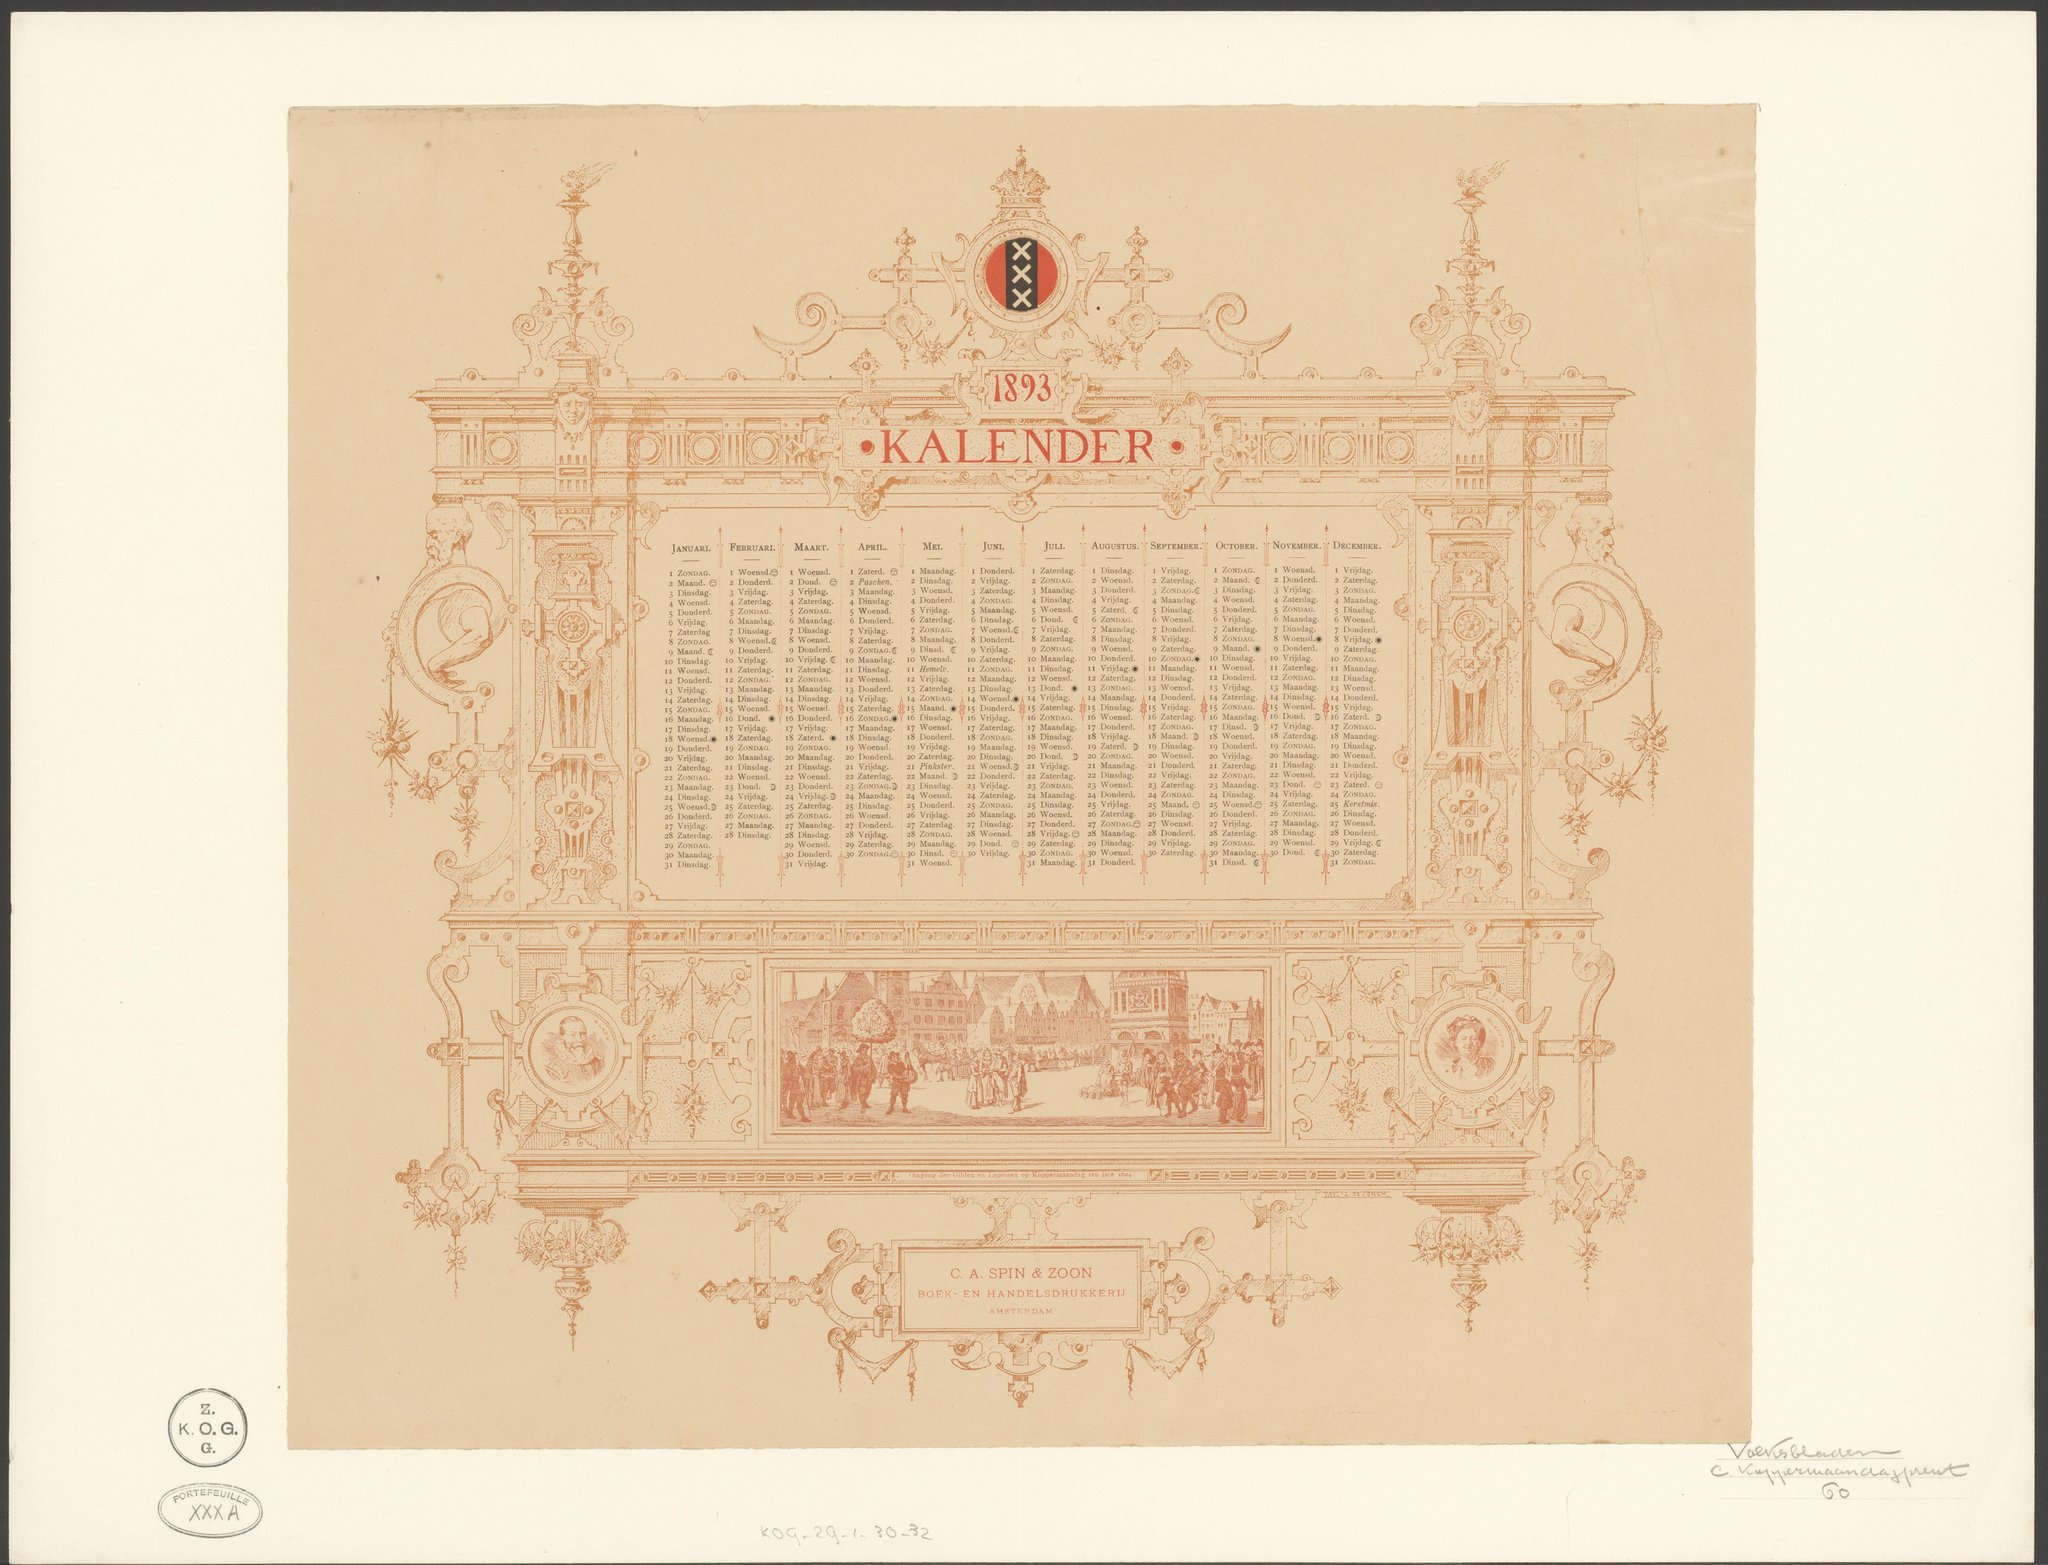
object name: calendar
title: Kalender van het jaar 1893, met architectonische omlijsting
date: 1893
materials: paper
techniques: letterpress printing, printing block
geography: amsterdam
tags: 'blue monday', calendar, almanac, amsterdam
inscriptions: collector's mark: Lugt 1641, stamp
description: Onderwerpsrubrieken binnen de Atlas Zeden en Gewoonten: Zeden en Gewoonten in engeren zin. Volksleven. Volksbladen. Koppermaandagwenschen.